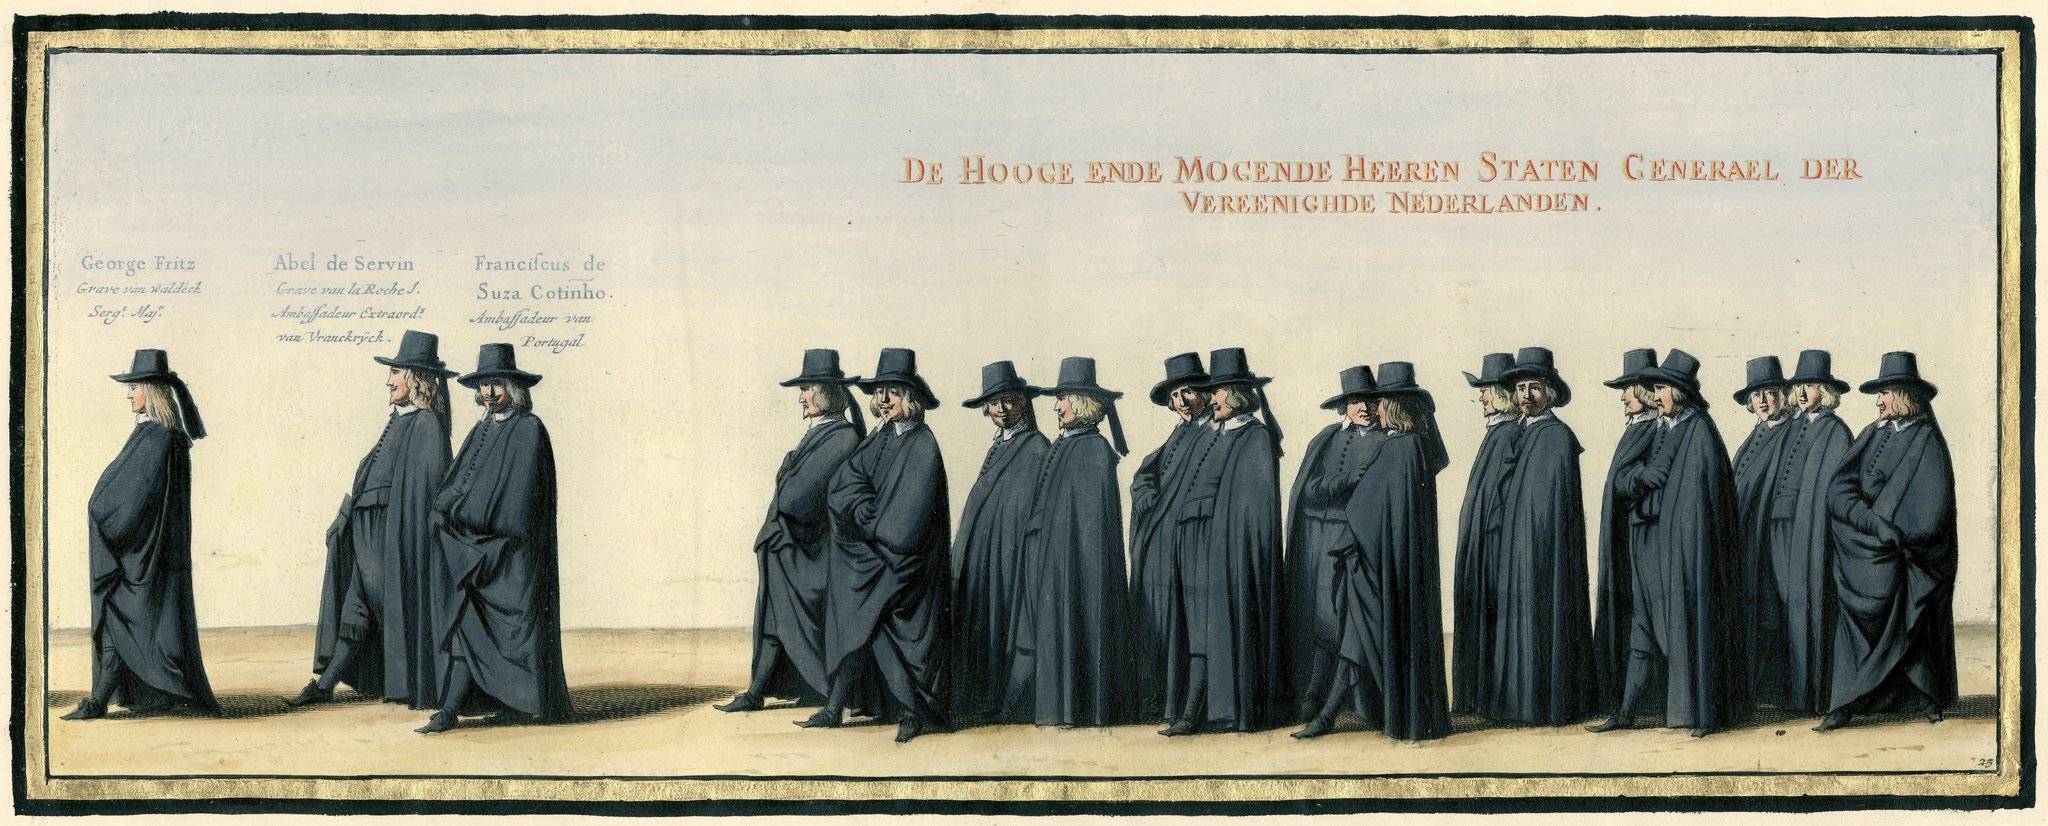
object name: book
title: Begraeffenisse van syne hoogheyt Frederick Henrick. Luxe ingekleurde uitgave van de prenten van de begrafenisstoet van Frederik Hendrik in 1647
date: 1651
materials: paint, paper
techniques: colour, etching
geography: the hague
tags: the hague, frederick henry (prince of orange)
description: De begrafenisstoet van Frederik Hendrik, plaat nr. 25 met de leden van de Staten-Generaal. Ingekleurde prent in een omlijsting versierd met goud en ingeplakt in de luxe editie uit ca. 1755 van het boek 'Begraeffenisse van syne hoogheyt Frederick Henrick' van Pieter Post, uitgegeven te Amsterdam in 1651.